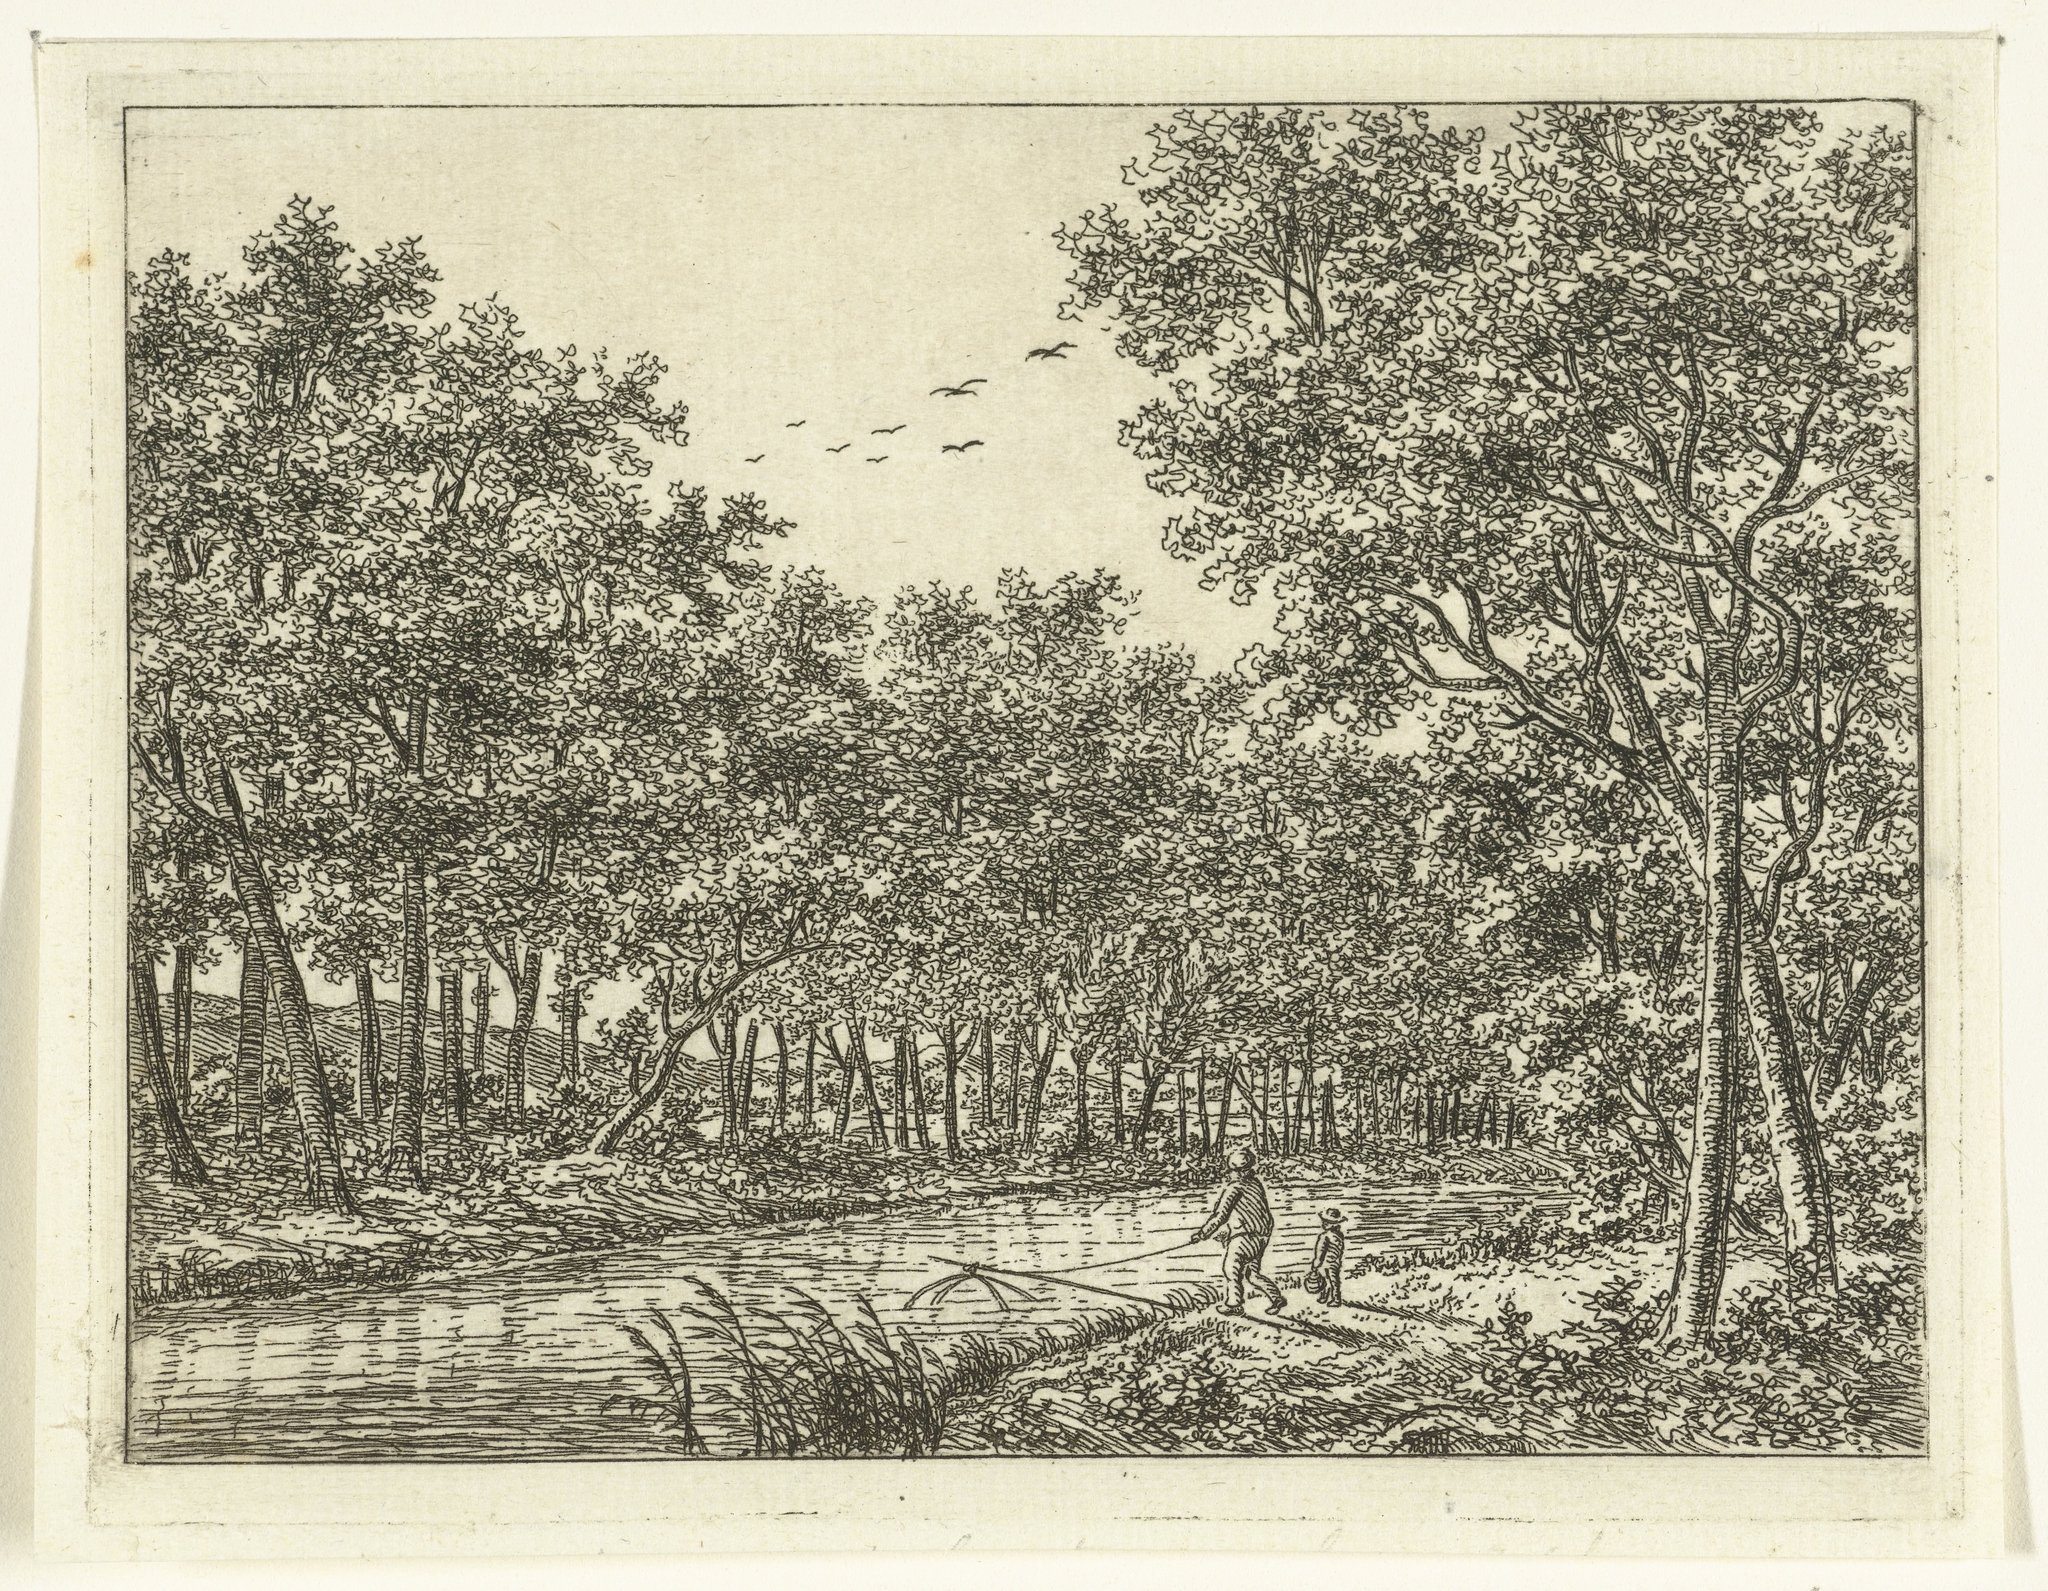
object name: print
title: Rivierlandschap met visser en jongetje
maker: ernst willem jan bagelaar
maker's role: draughtsman, print maker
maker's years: 1775-1837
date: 1798-1837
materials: paper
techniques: etching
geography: netherlands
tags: river (+ landscape with figures, staffage)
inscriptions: collector's mark: Lugt 2228